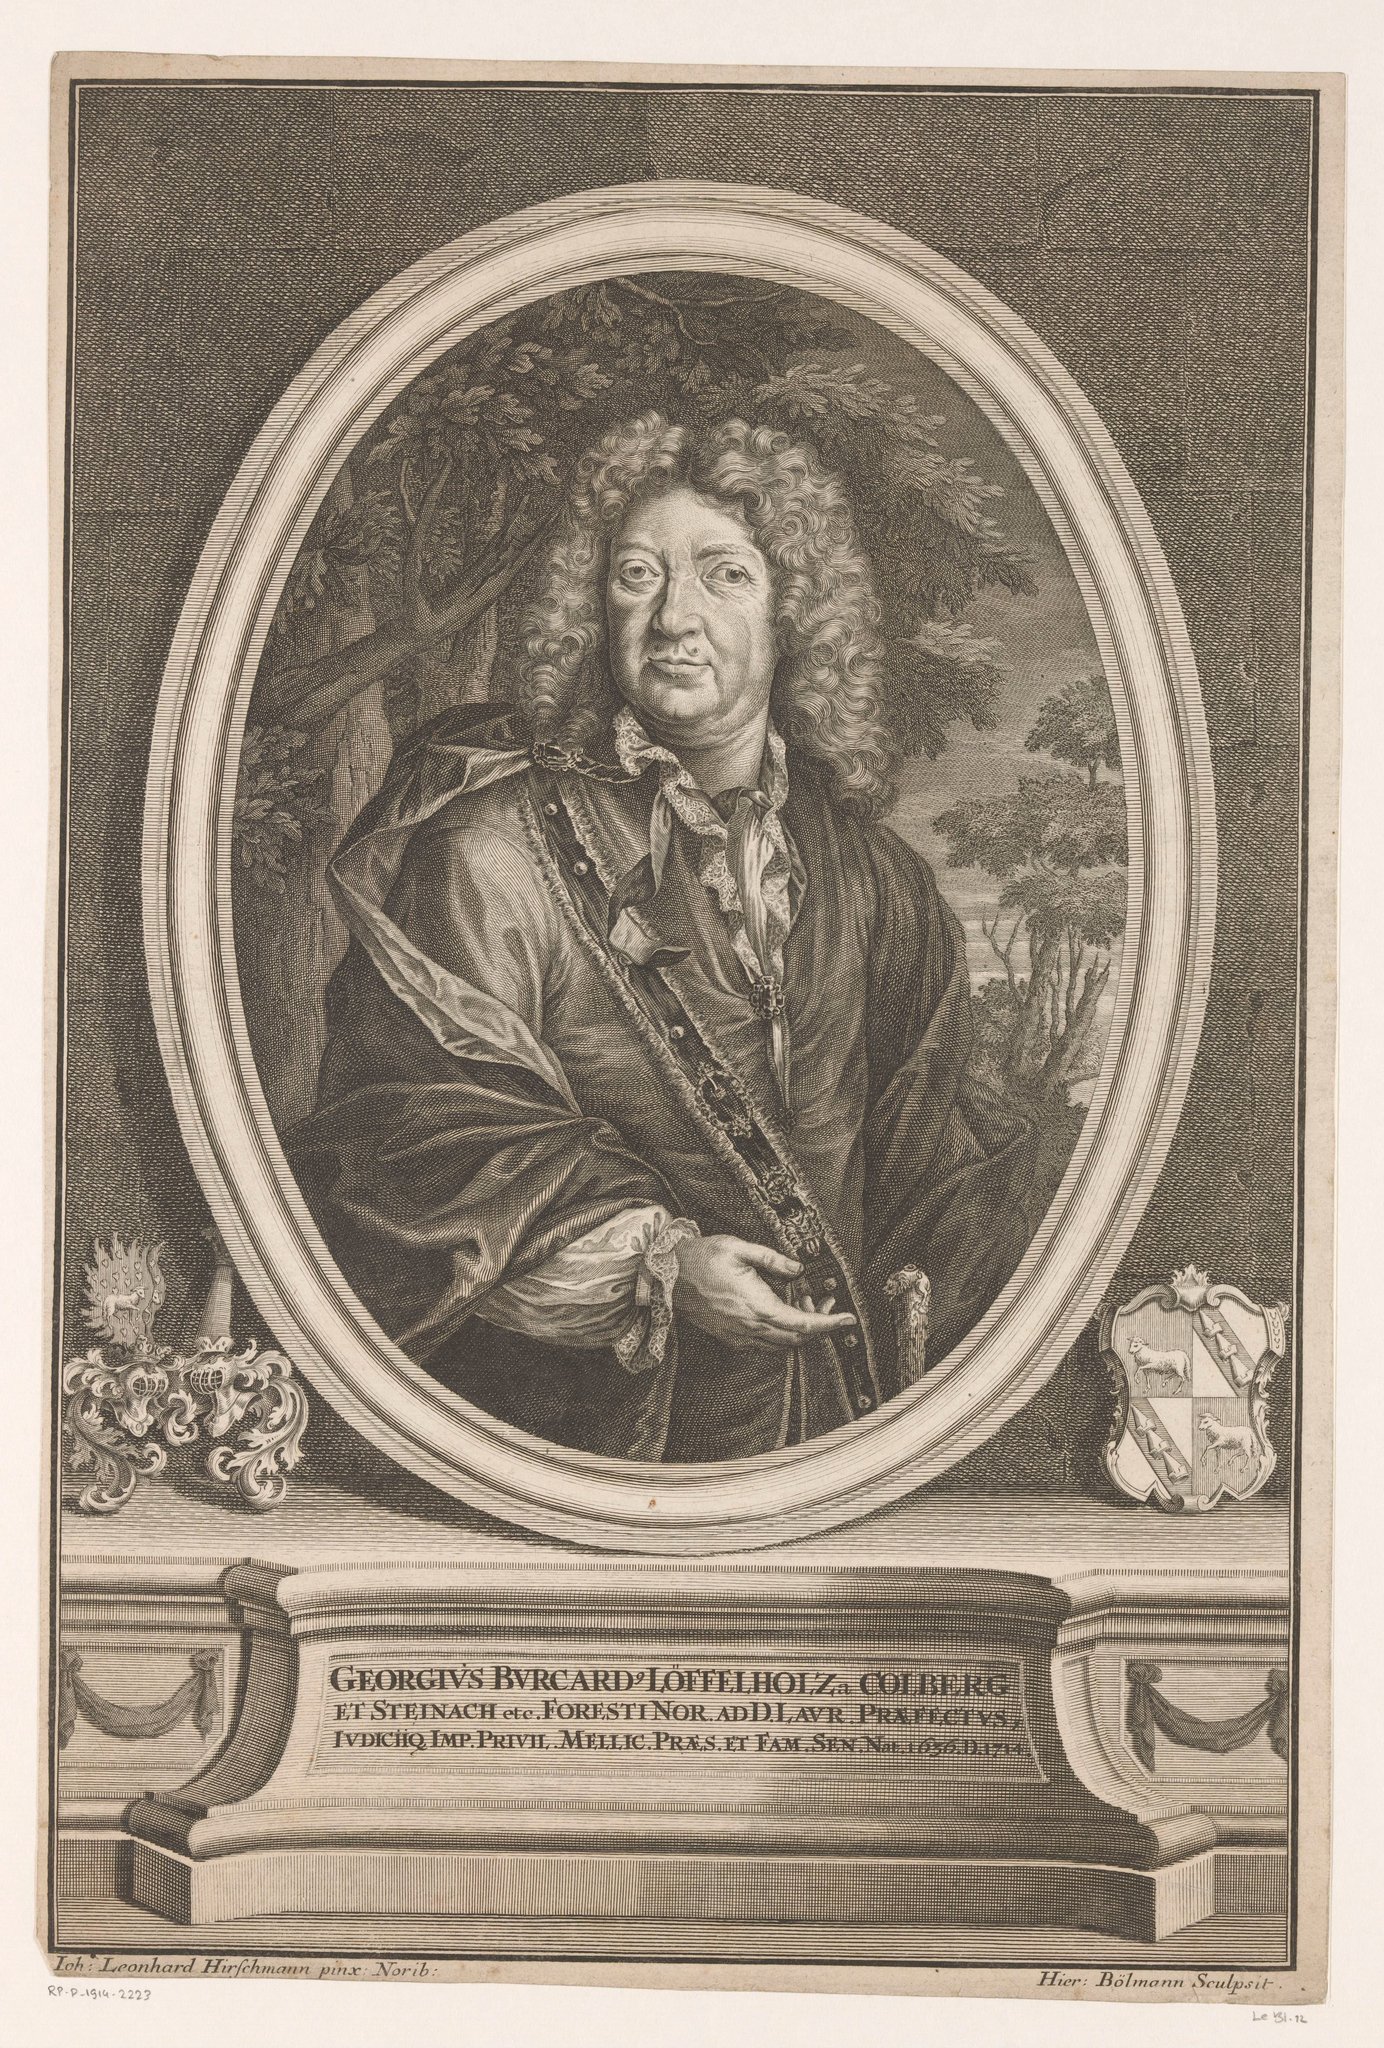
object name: print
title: Portret van Georg Burkhard Löffelholz von Colberg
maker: johann leonhard hirschmann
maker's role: painter, print maker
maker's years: 1672-1750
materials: paper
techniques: engraving, etching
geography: nuremberg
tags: trees, walking-stick, staff, historical persons, armorial bearing, heraldry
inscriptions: collector's mark: Lugt 2228